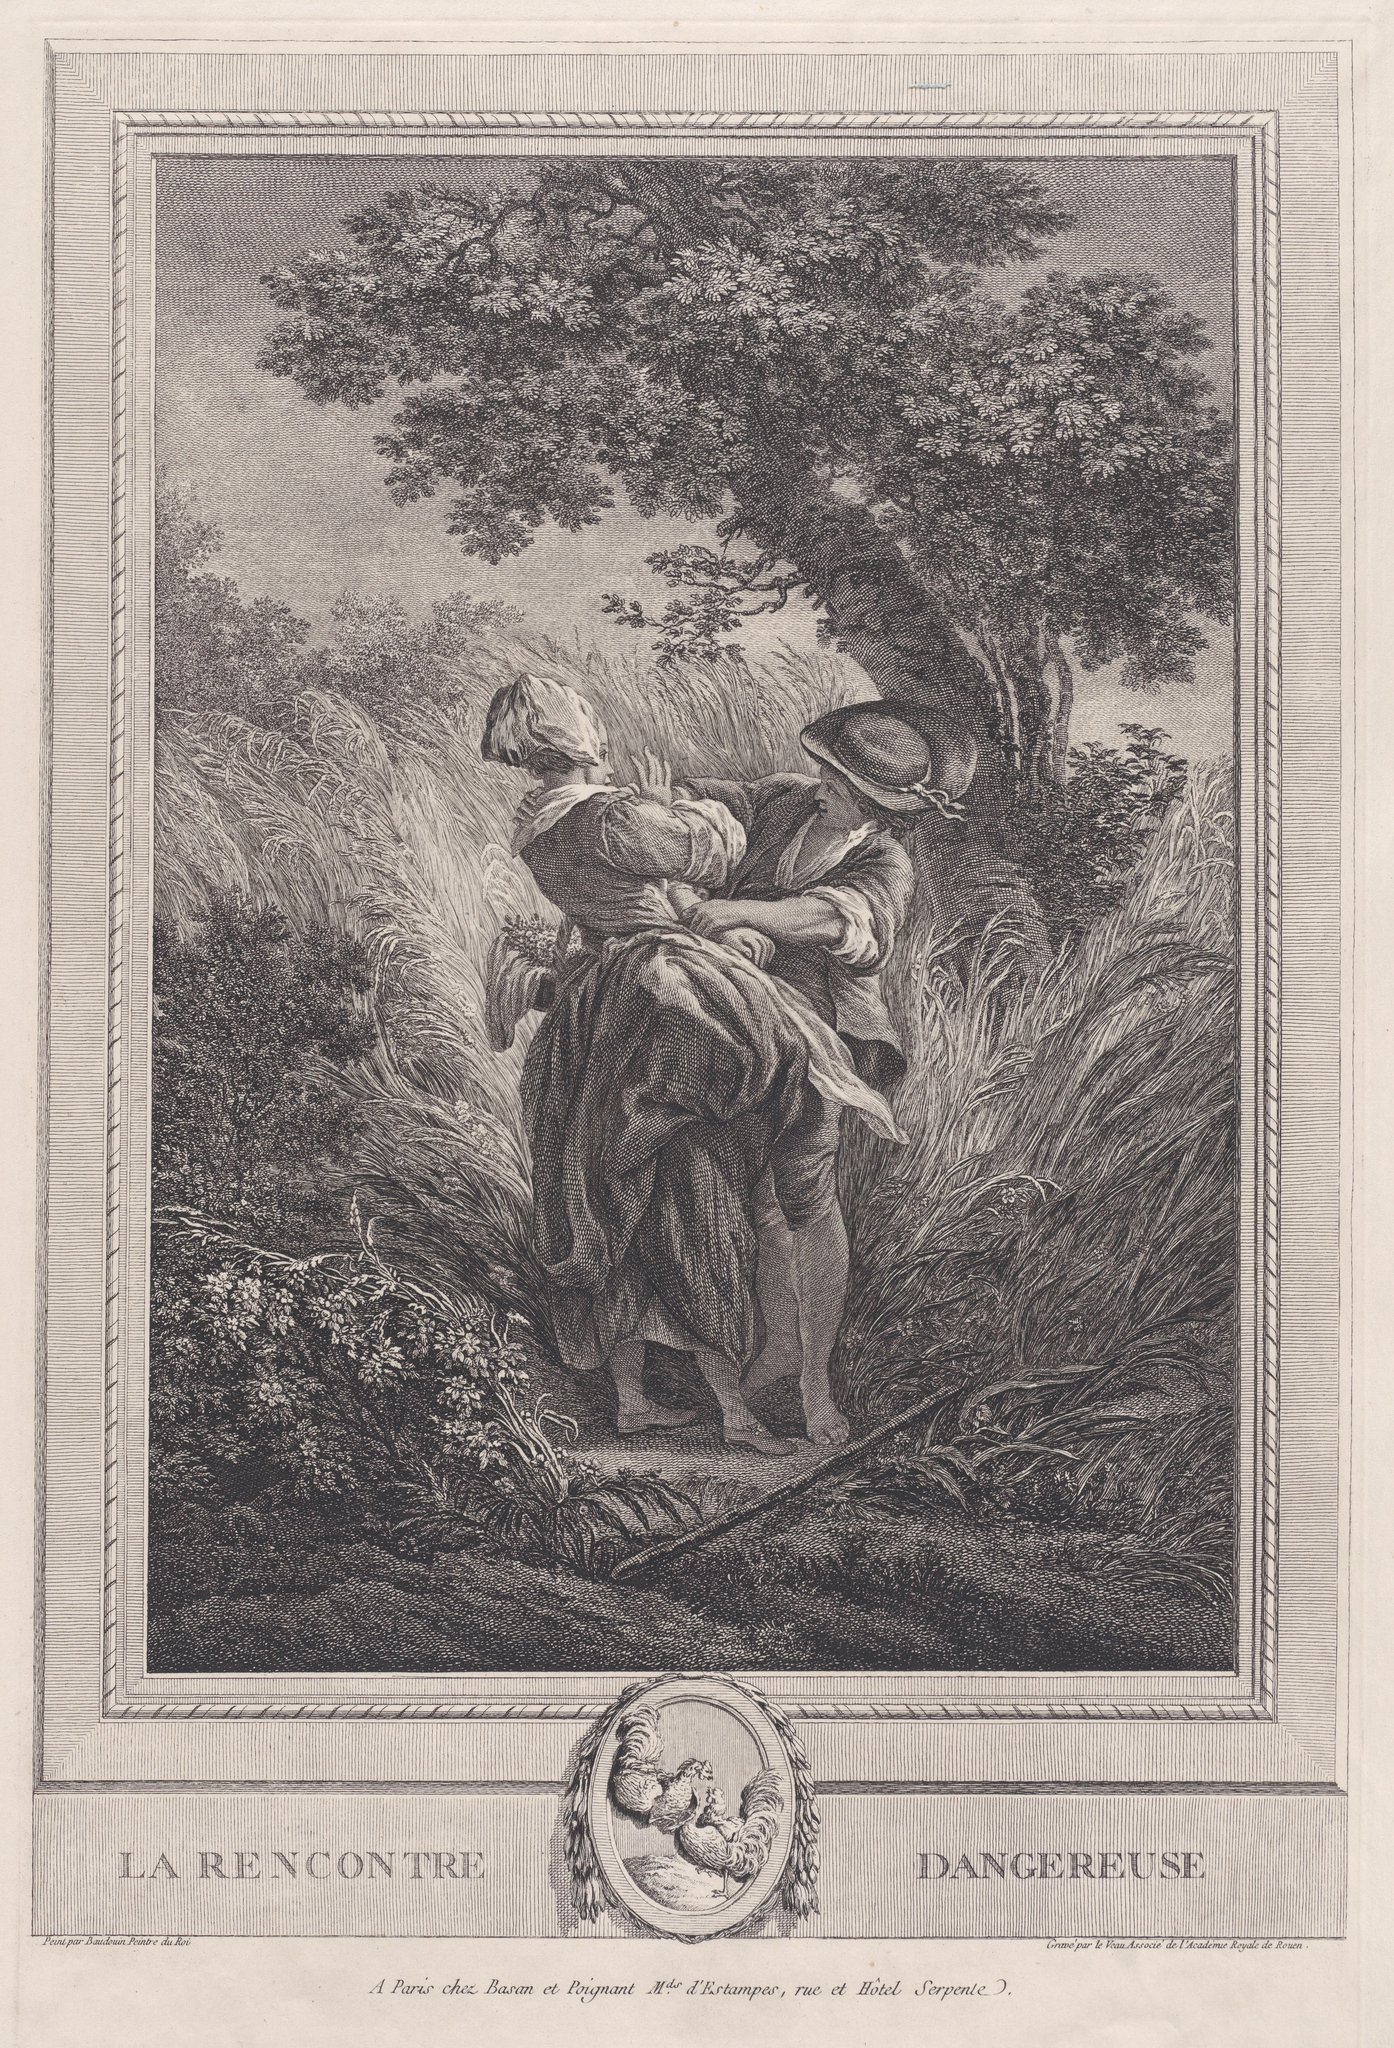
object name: print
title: La Rencontre Dangereuse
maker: pierre antoine baudouin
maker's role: artist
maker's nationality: french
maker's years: 1723-1769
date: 1701-1800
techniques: engraving